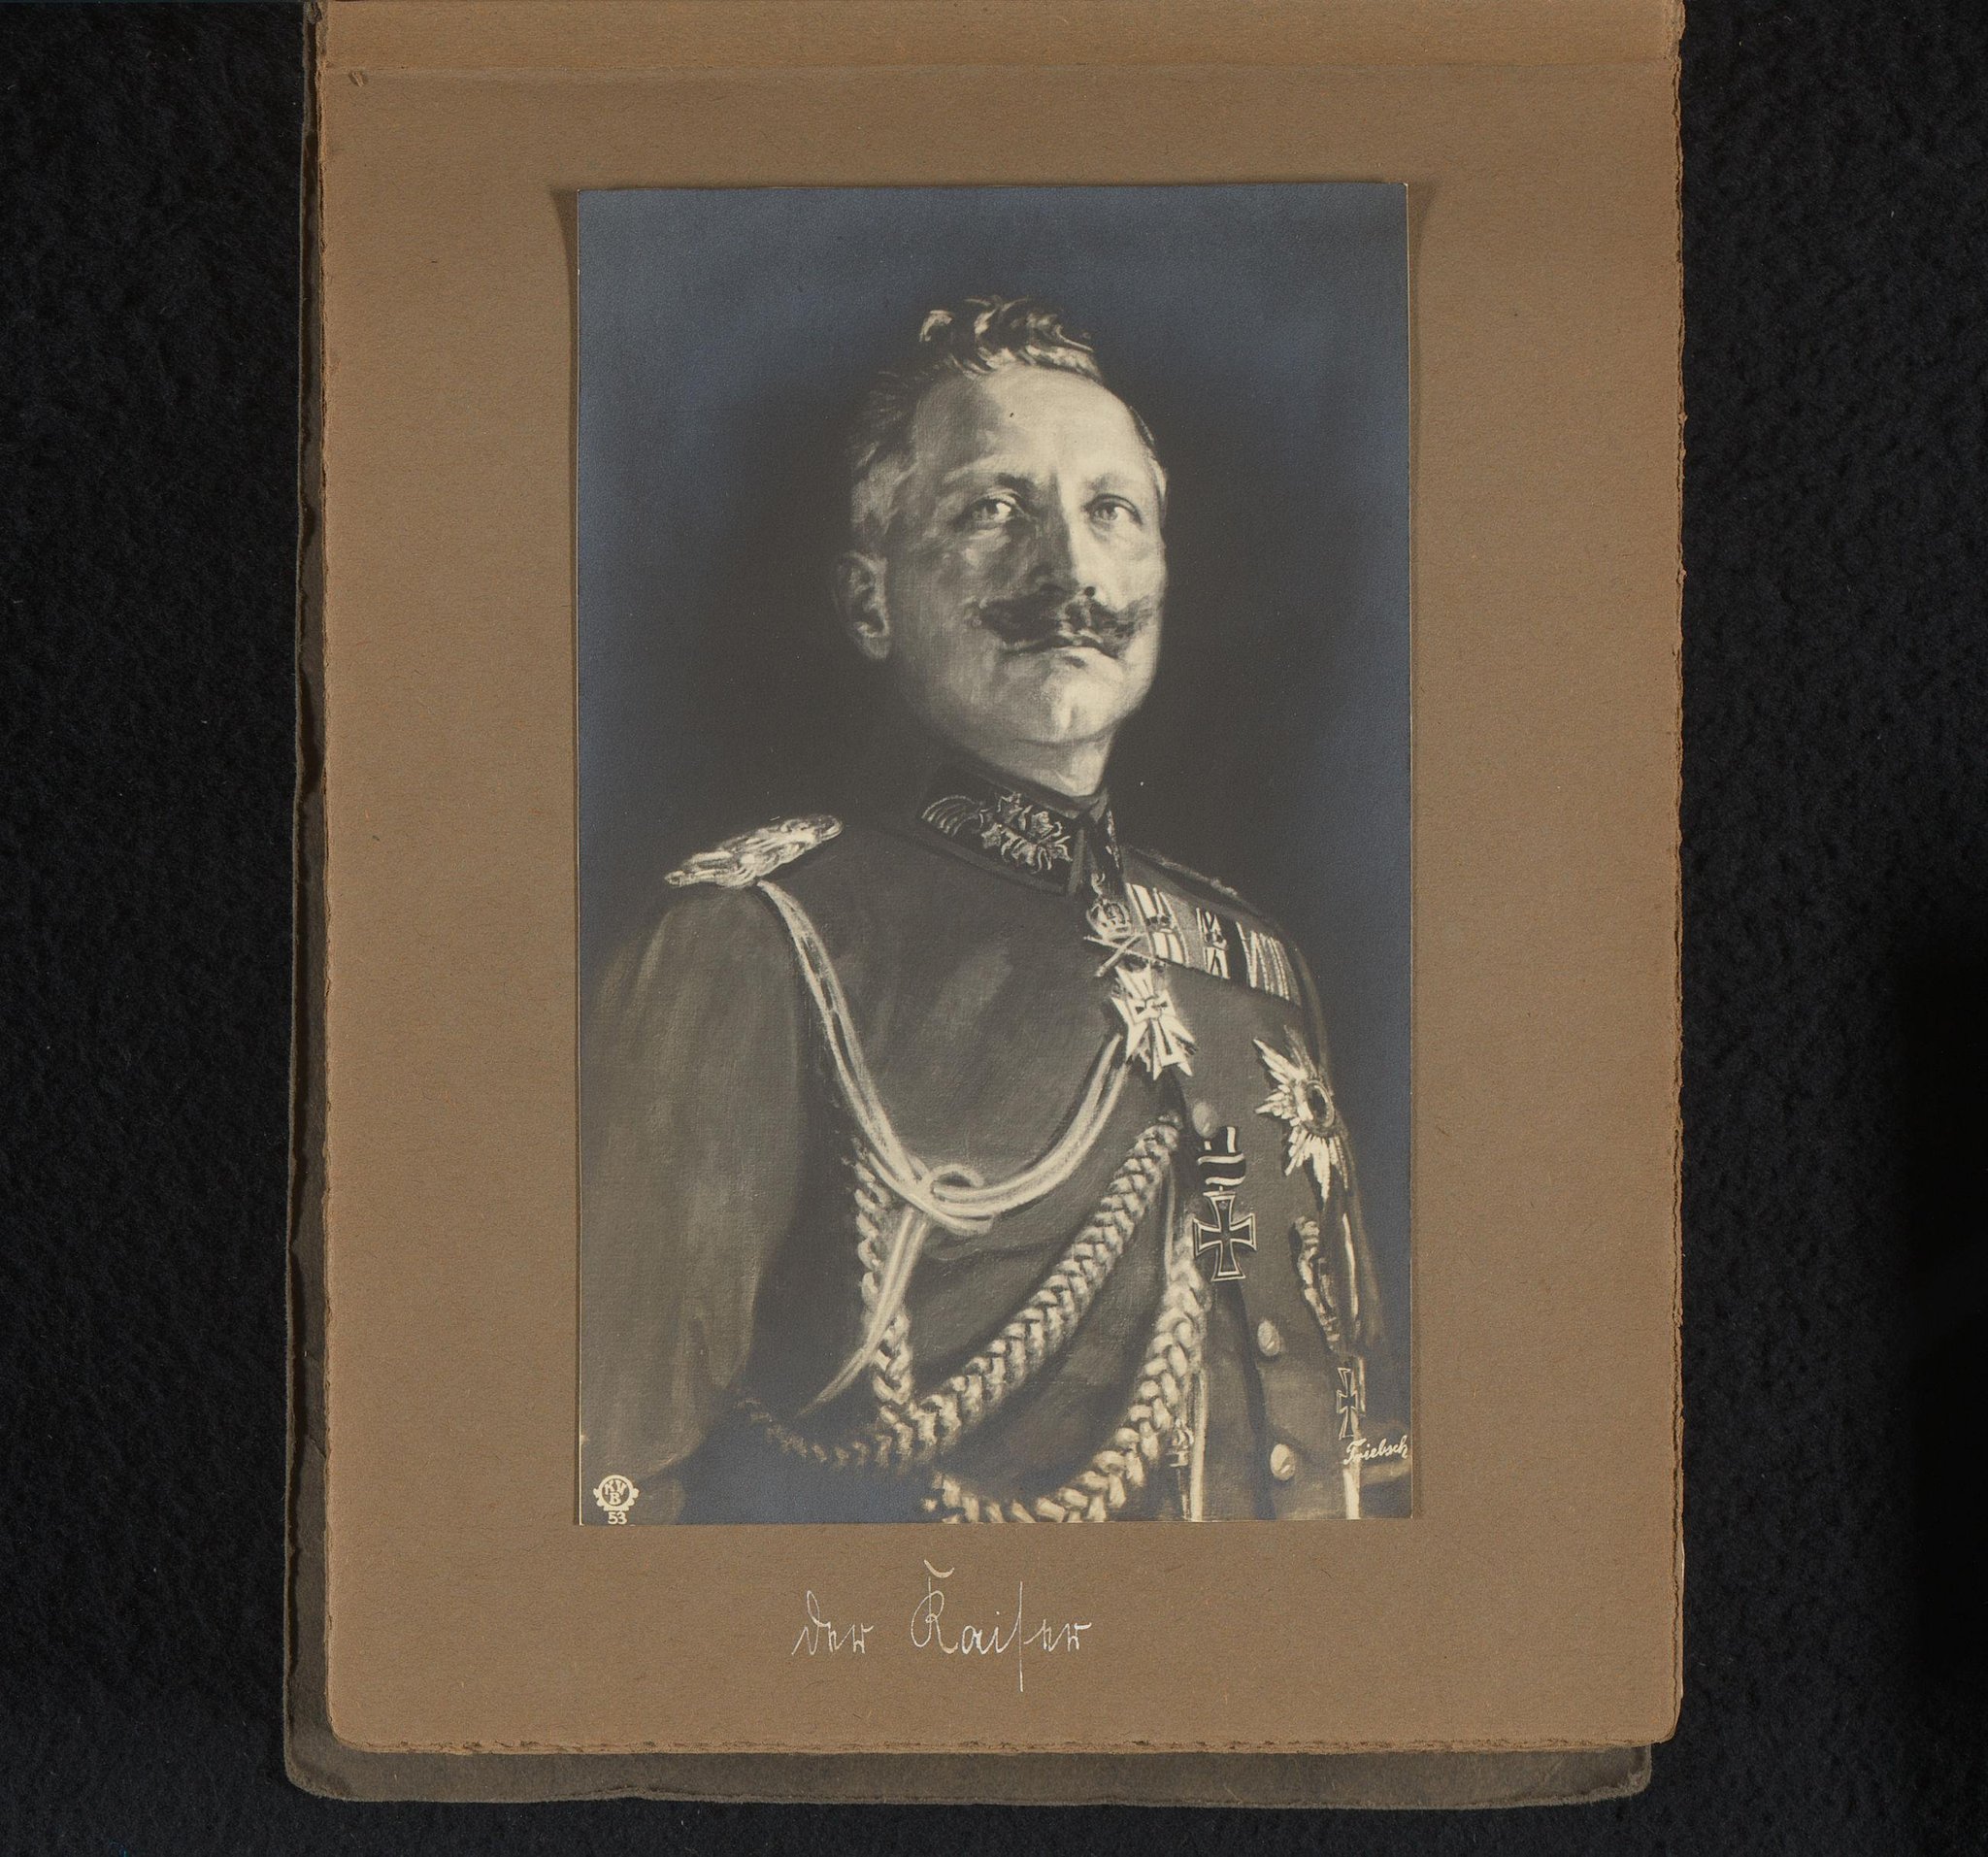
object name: reproduction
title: Fotoreproductie van een geschilderd portret van Wilhelm II van Duitsland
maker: Anonymous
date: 1902-1910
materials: paper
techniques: gelatin silver print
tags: wilhelm ii (keizer van duitsland), historical persons, emperor